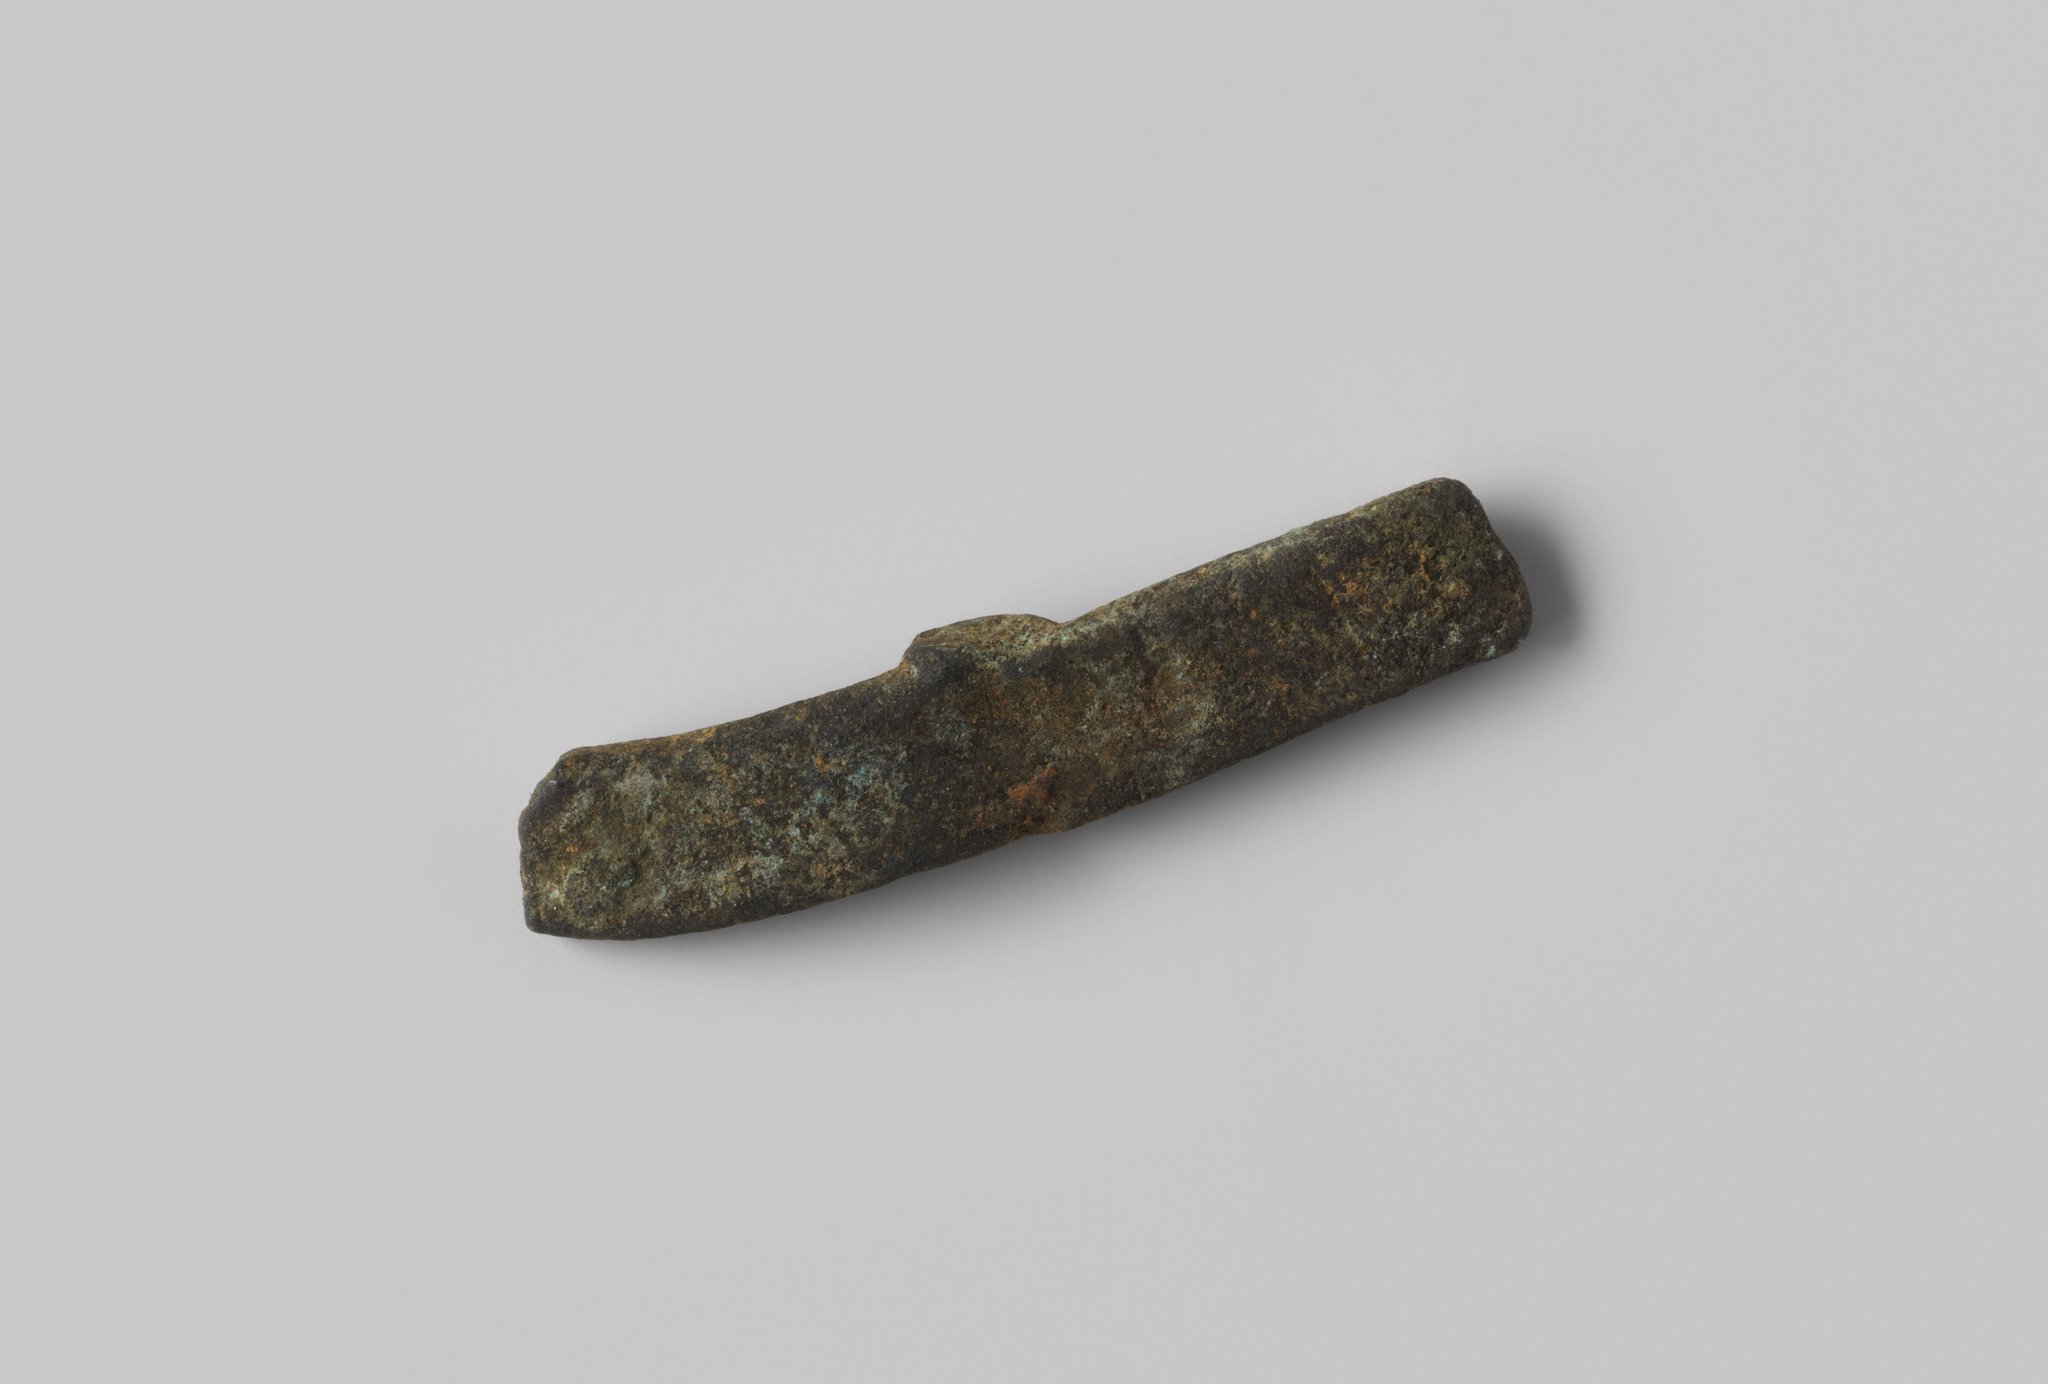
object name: belt buckle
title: Fragment riemgesp uit het wrak van de Oost-Indiëvaarder Hollandia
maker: Anonymous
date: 1700-1743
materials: copper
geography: netherlands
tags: verenigde oostindische compagnie, hollandia (schip), annet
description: Rectangular, fragm of ring, id. NG 1980-27H2796, belt buckle.